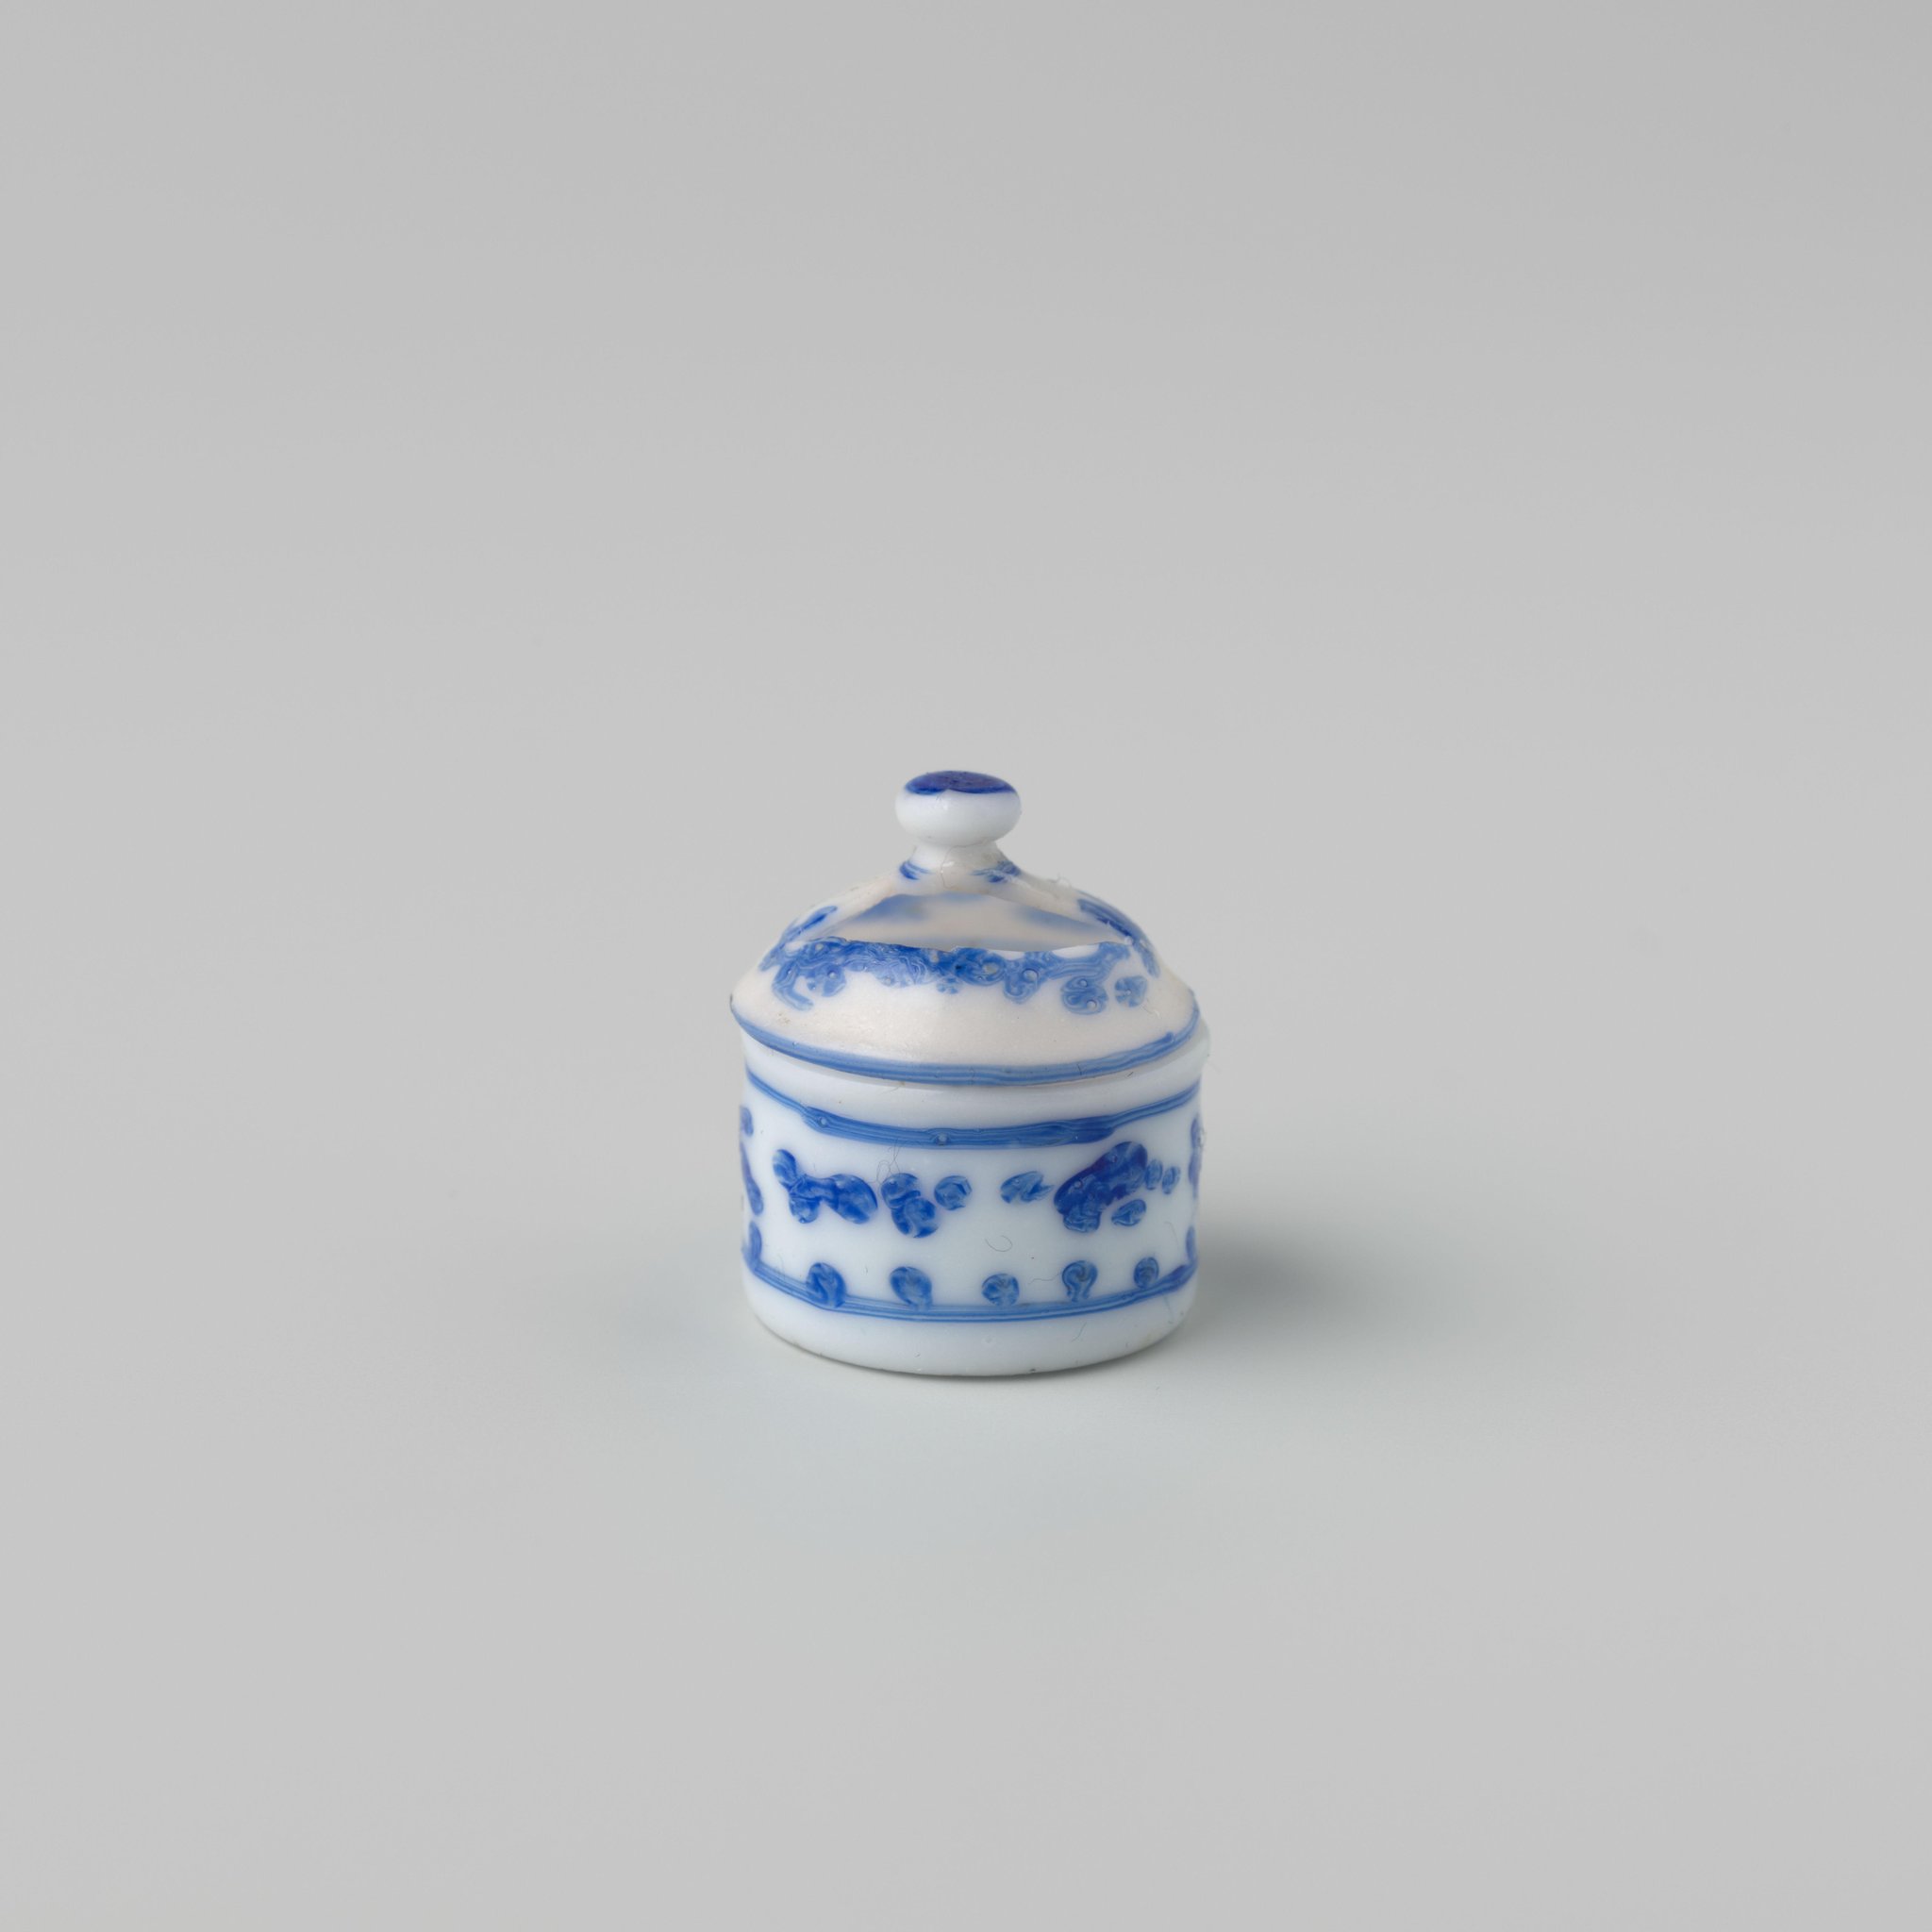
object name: pot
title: Pot met deksel van melkglas met blauwe emailverf beschildering, imitatie Chinees porselein; cilindrisch lage pot, waarop bolle deksel met knop, stippen en bloemmotieven.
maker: Anonymous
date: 1675-1710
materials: glass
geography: amsterdam